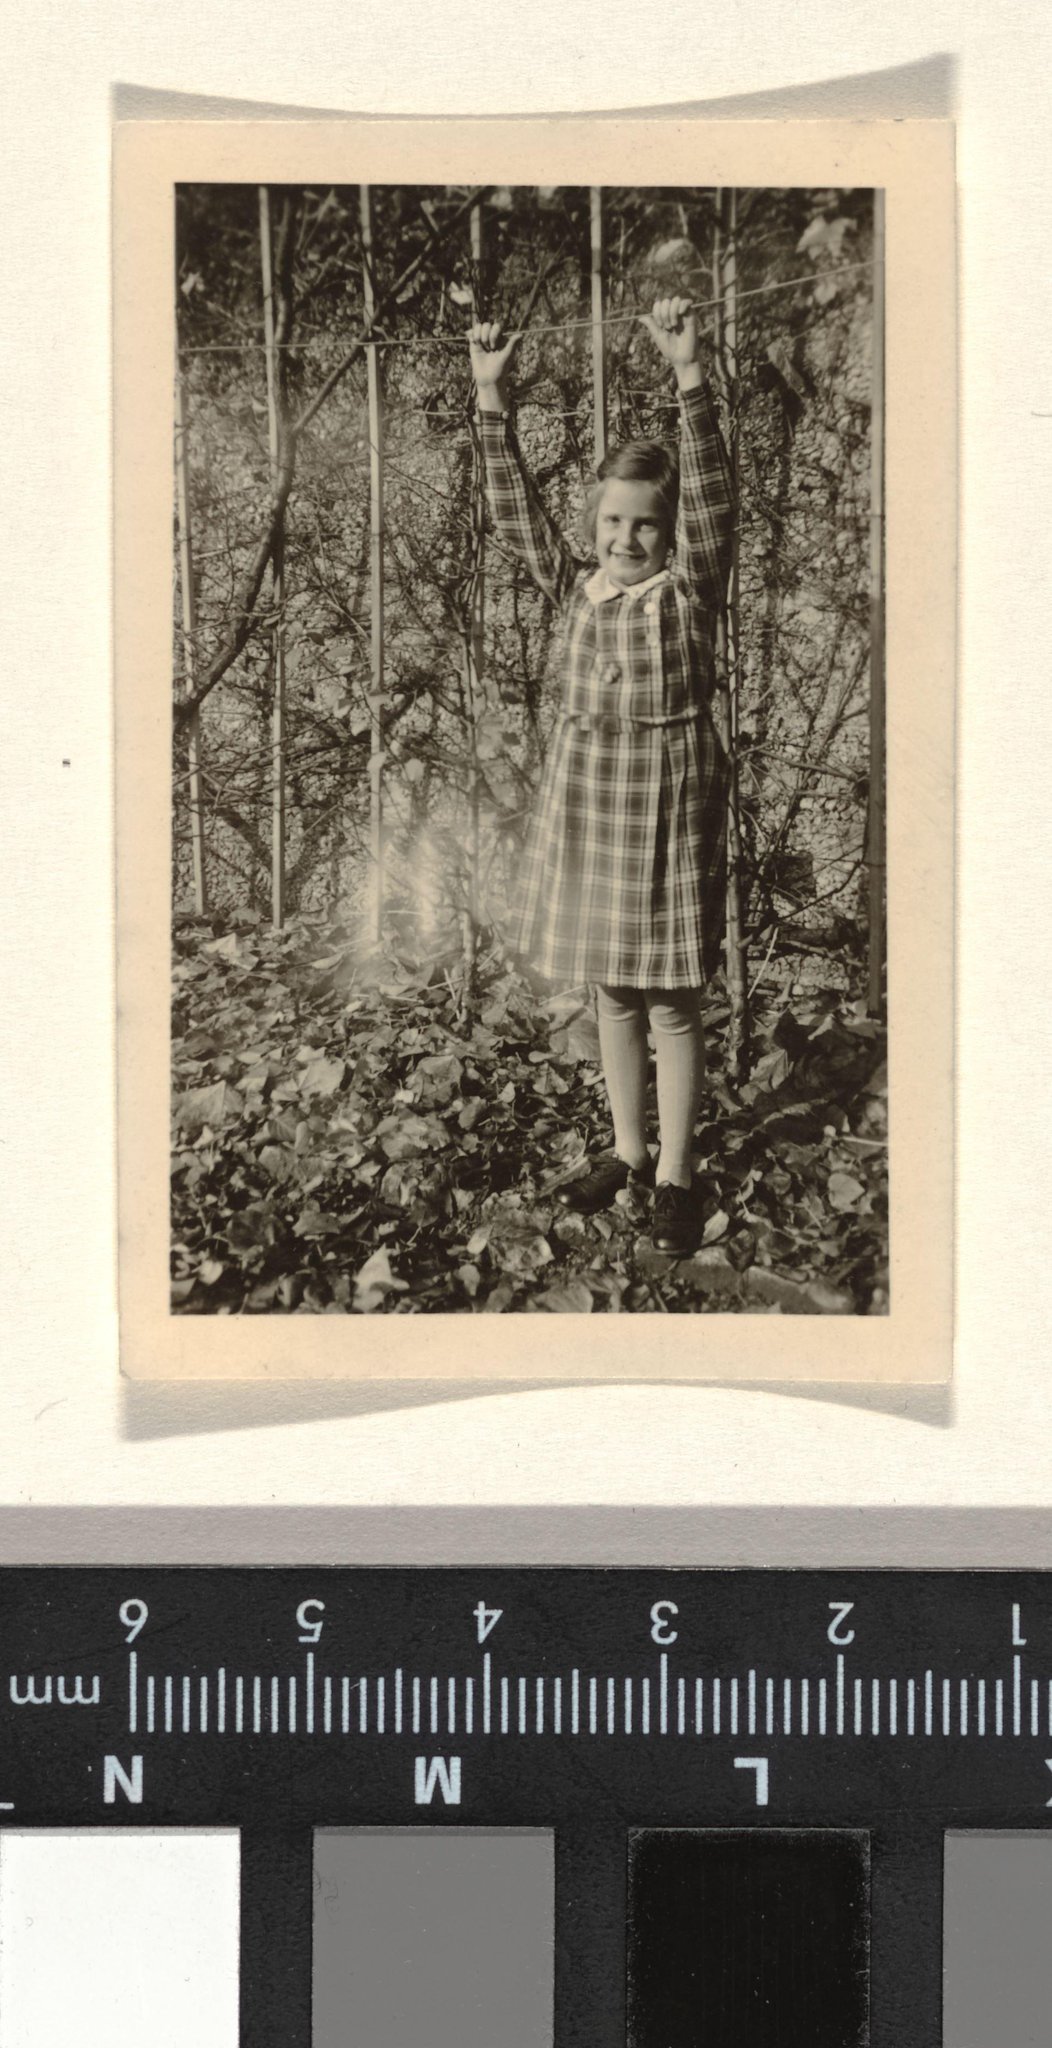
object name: photograph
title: Isabel Wachenheimer met gestrekte armen en handen op een touw voor een vijver, oktober 1936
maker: Anonymous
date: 1910-1936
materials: photographic support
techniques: gelatin silver print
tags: leiden, isabel wachenheimer-elon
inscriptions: date: ‘Oktober 1936.’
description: Isabel Wachenheimer met gestrekte armen en handen op een touw voor een vijver.